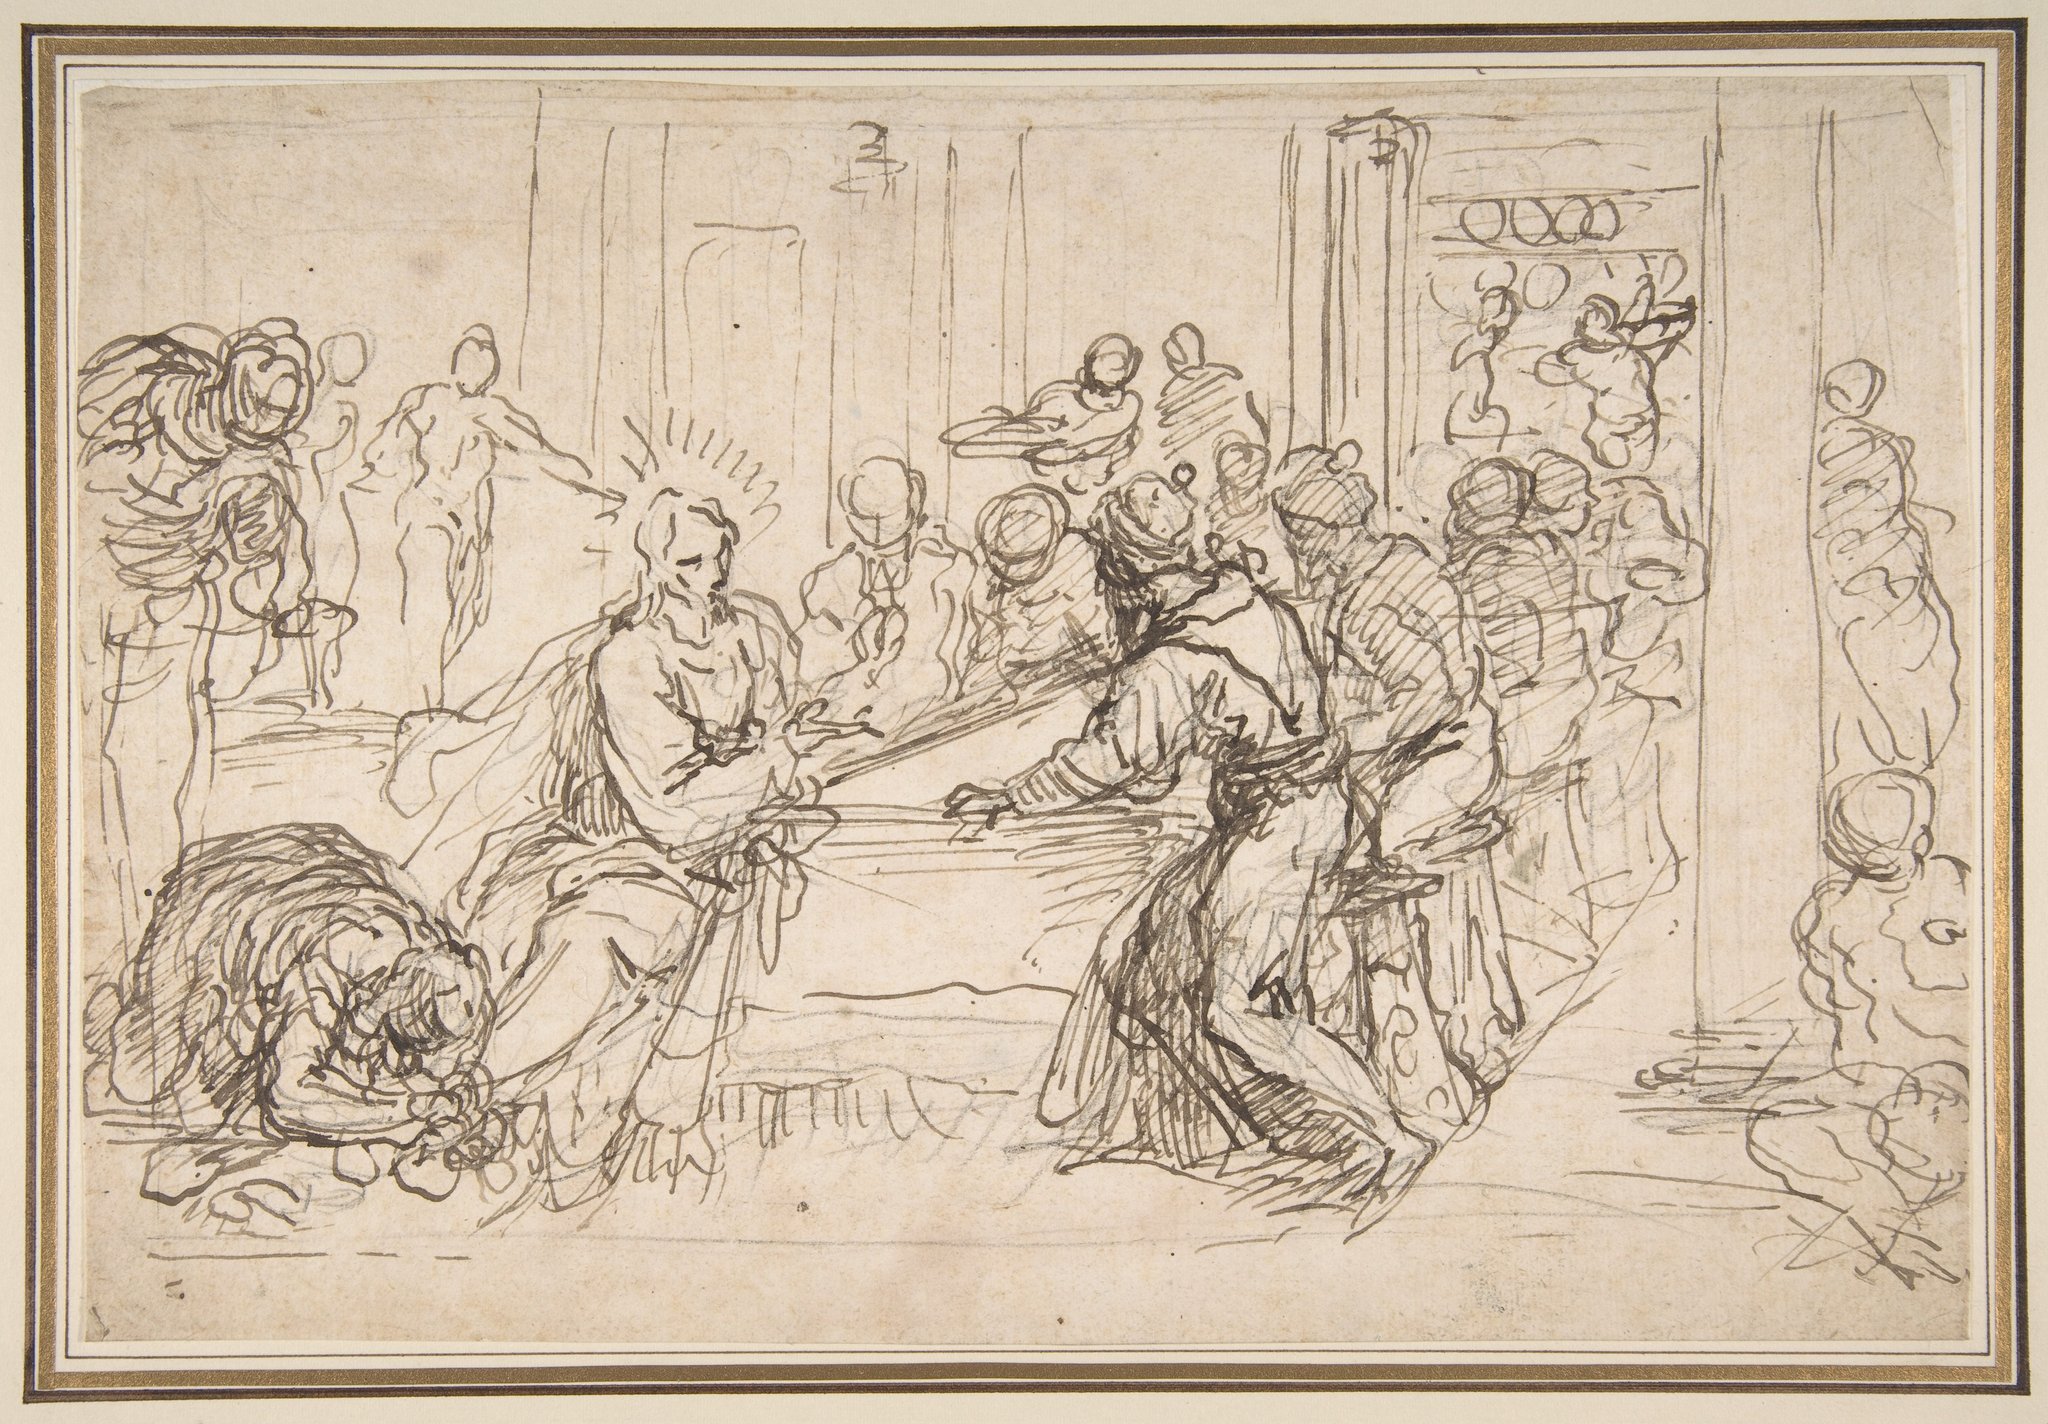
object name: drawing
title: Penitent Woman Anointing the Feet of Christ at the Table of Simon the Pharisee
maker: jacopo palma the younger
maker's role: artist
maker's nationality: italian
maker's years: 1543-1628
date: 1548-1628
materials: chalk, ink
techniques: pen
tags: women,christ